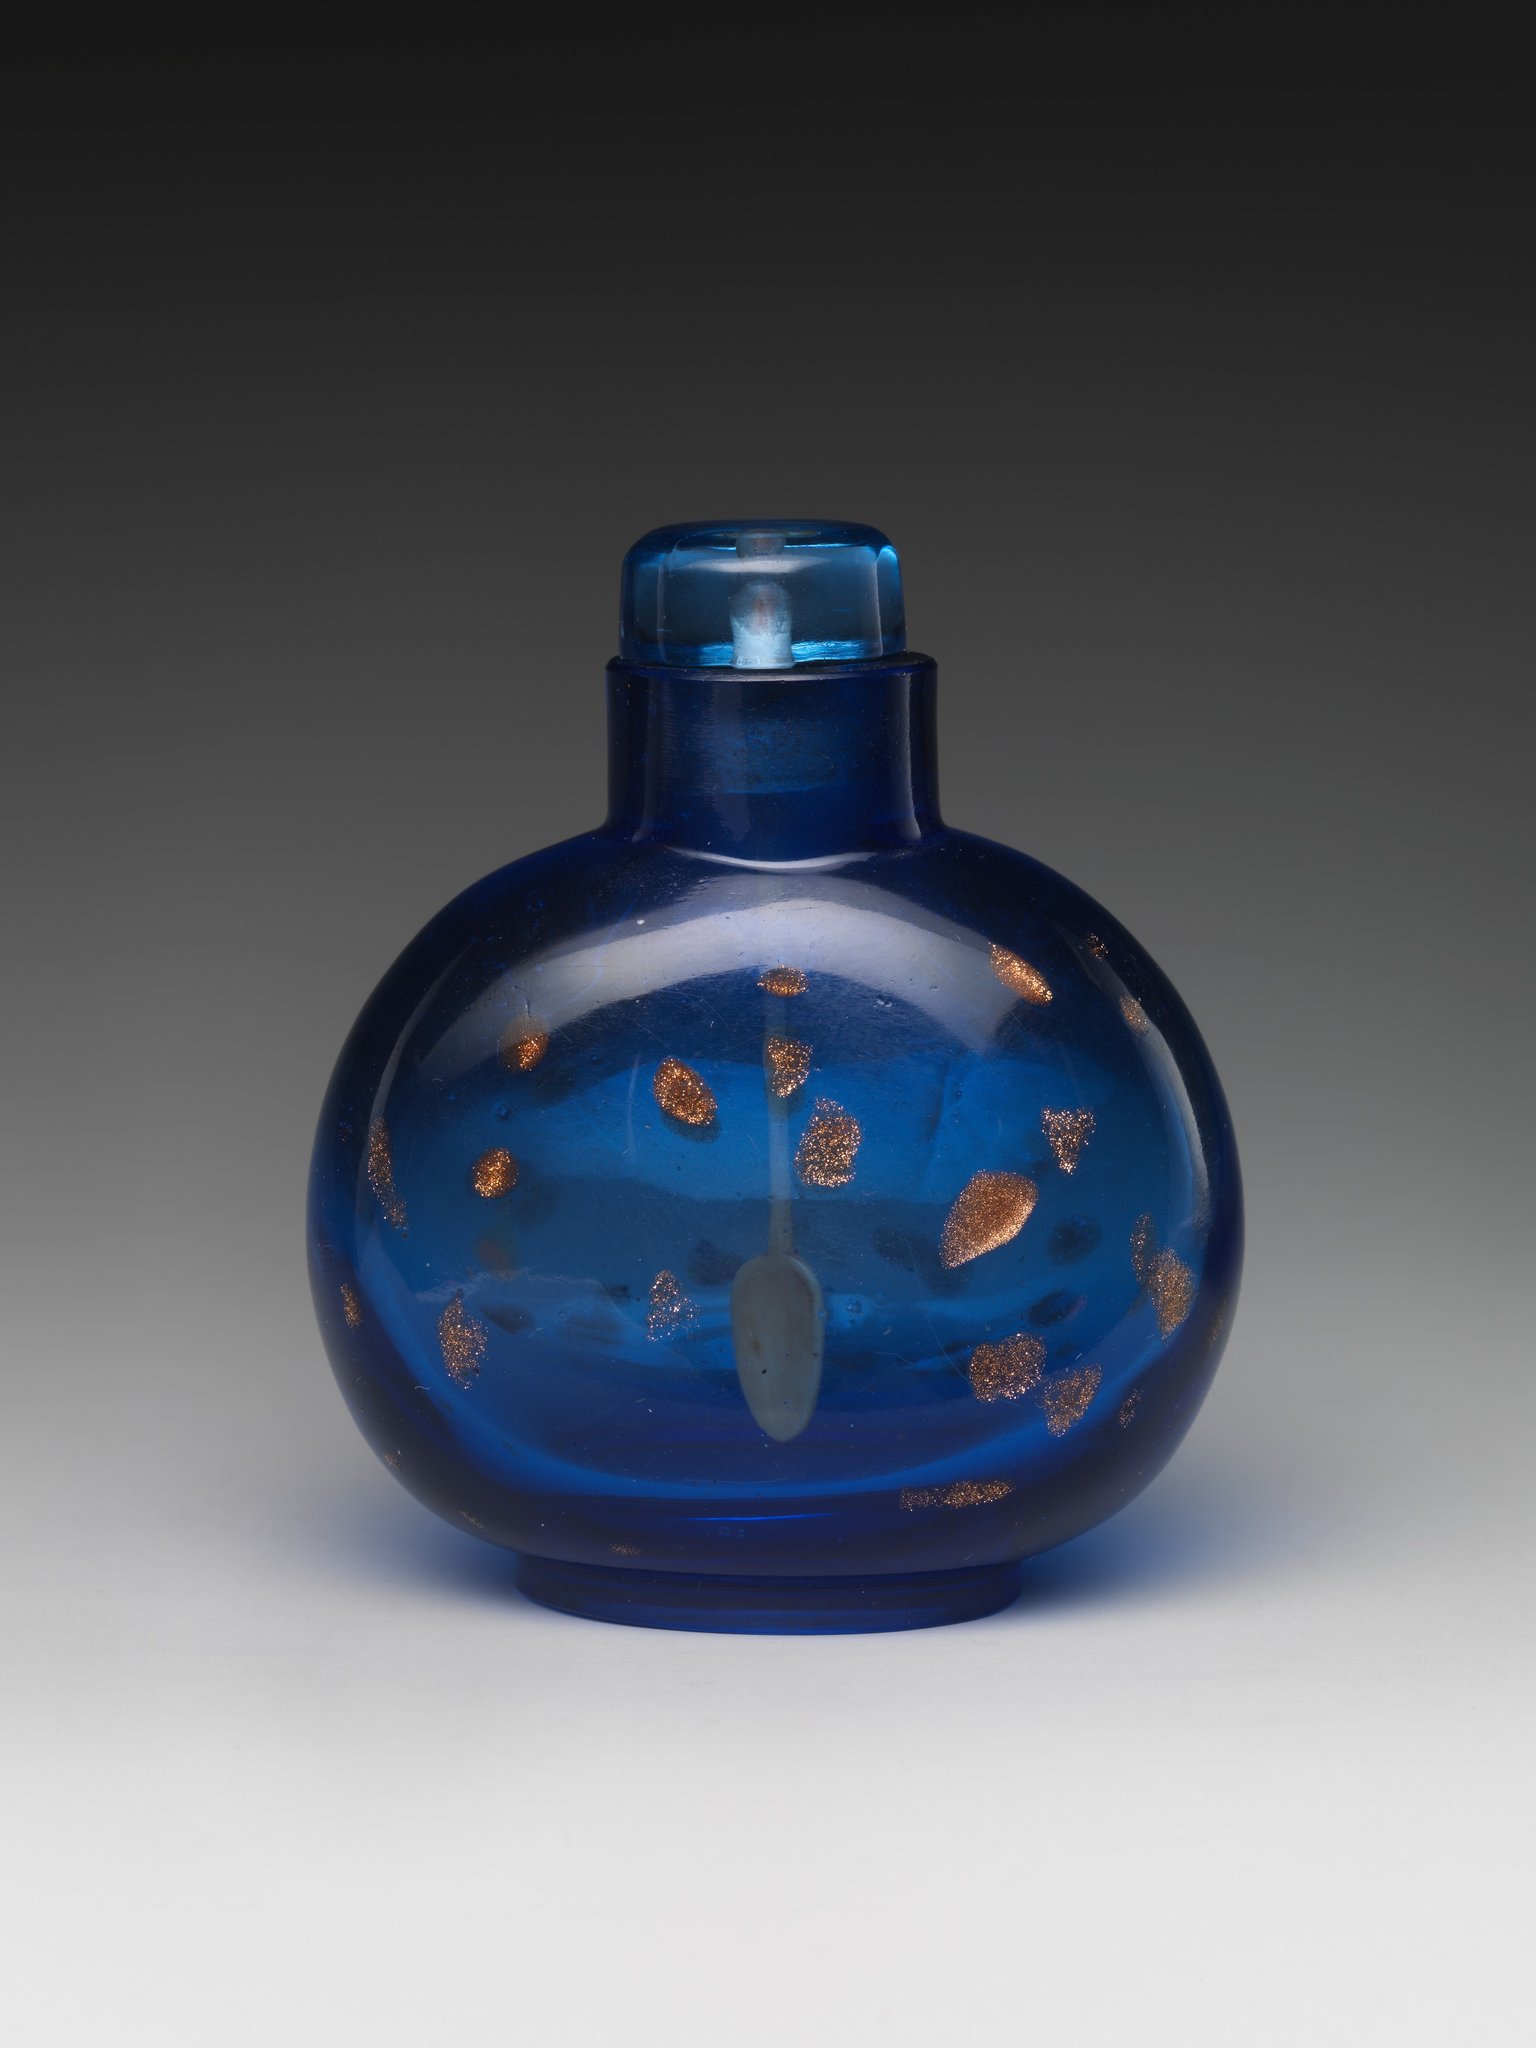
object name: snuff bottle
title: Snuff Bottle with Gold Speckles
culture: chinese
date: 1767-1800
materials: glass